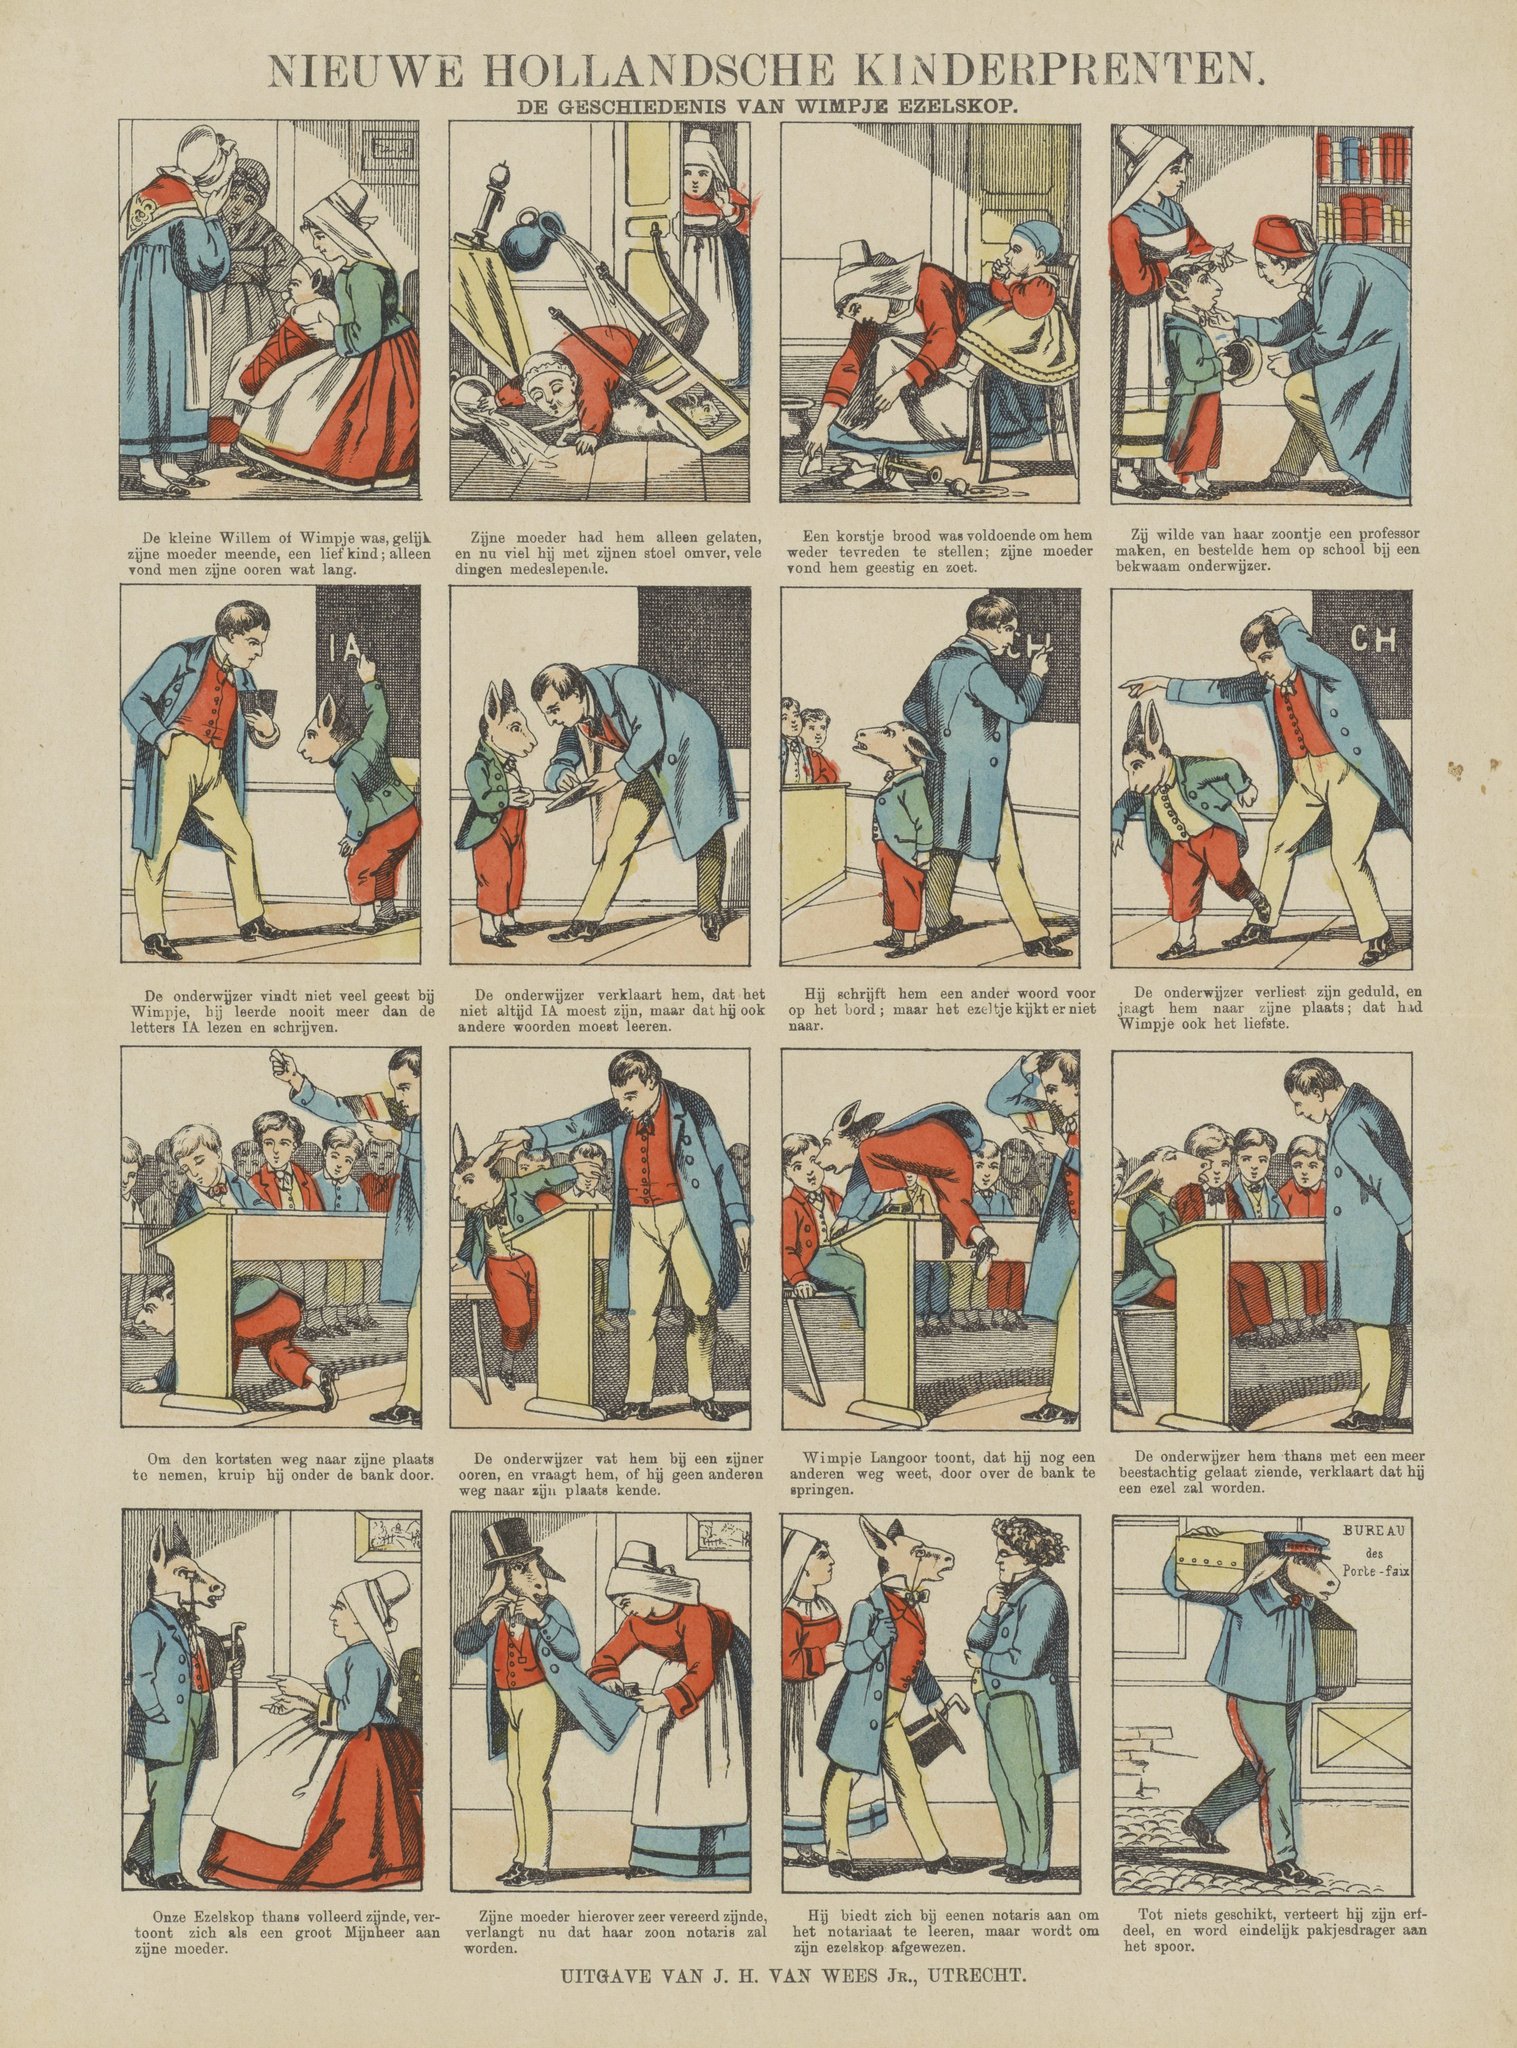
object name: print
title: De geschiedenis van wimpje ezelskop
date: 1869-1888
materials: paper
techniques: colour, letterpress printing, lithograph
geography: europe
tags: ass, donkey, disabilities, deformations and monstrosities; diseases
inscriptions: collector's mark: Lugt 2760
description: Blad met 16 voorstellingen over het leven van het jongetje Wimpje met een ezelskop. Onder elke afbeelding een onderschrift.